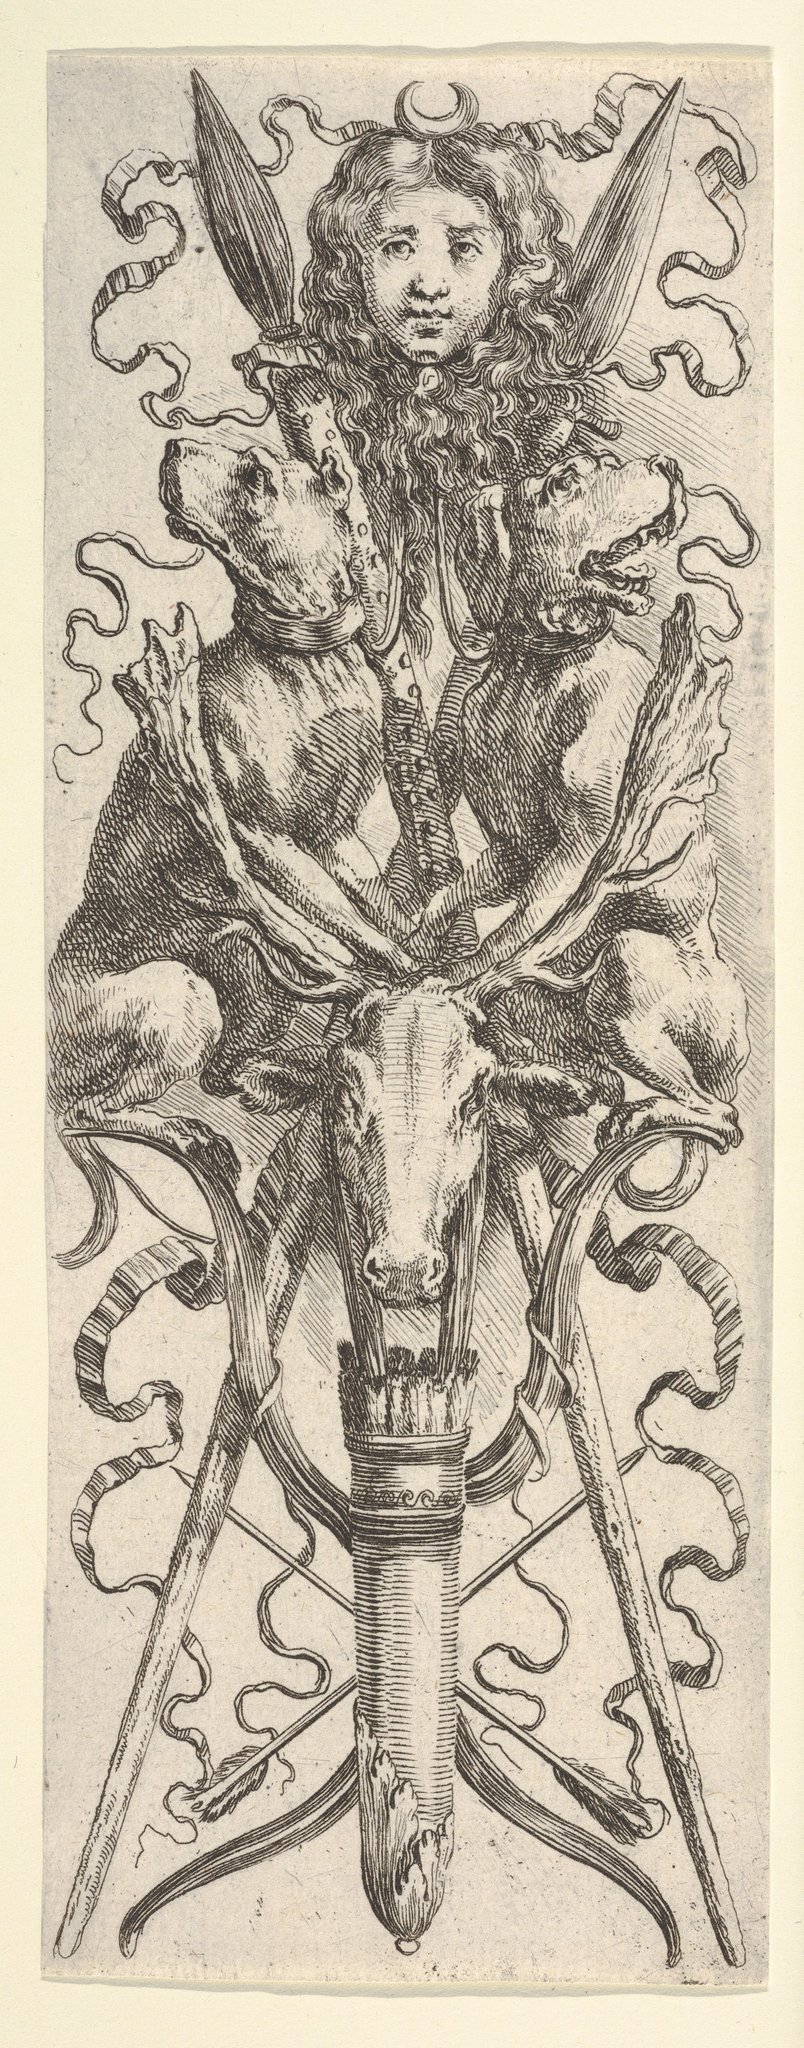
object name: print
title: A hunting trophy: a quiver, two arrows, two bows, a deer head, two dogs, two spears, and the head of Diana at top, from "Ornaments or Grotesques" (Ornamenti o Grottesche)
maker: stefano della bella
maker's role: artist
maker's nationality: italian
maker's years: 1610-1664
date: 1650-1656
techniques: etching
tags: bow and arrow,diana,deer,dogs,trophies